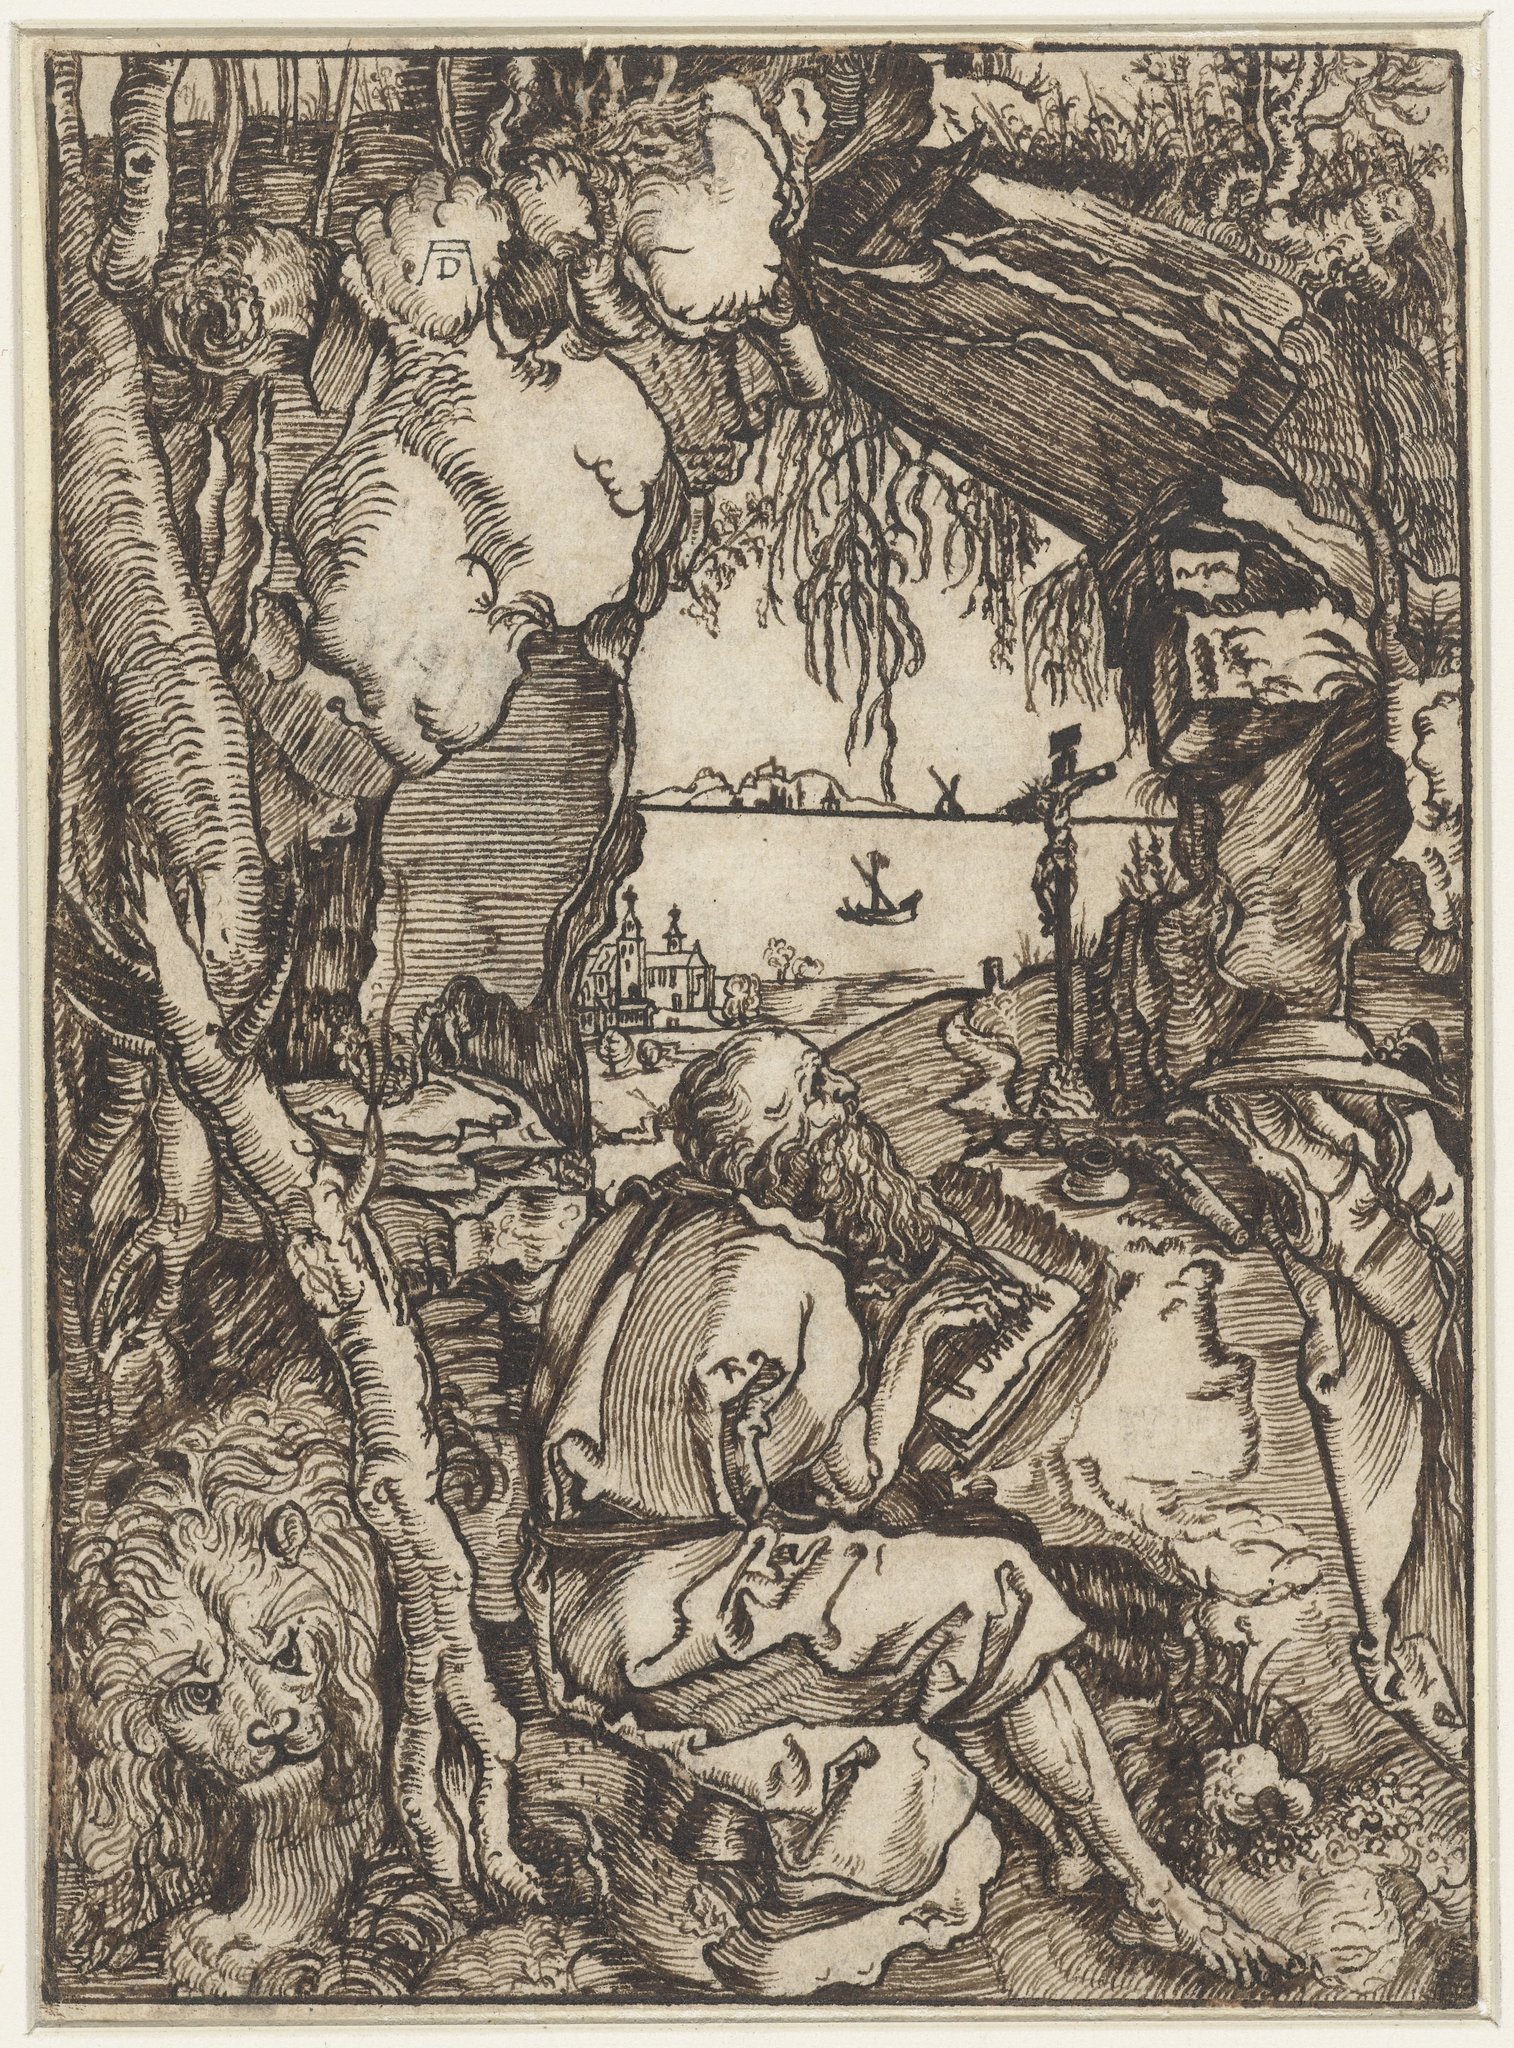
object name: drawing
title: H. Hieronymus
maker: Anonymous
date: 1512-1600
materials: ink, paper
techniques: pen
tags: st. jerome as hermit in a landscape, reading